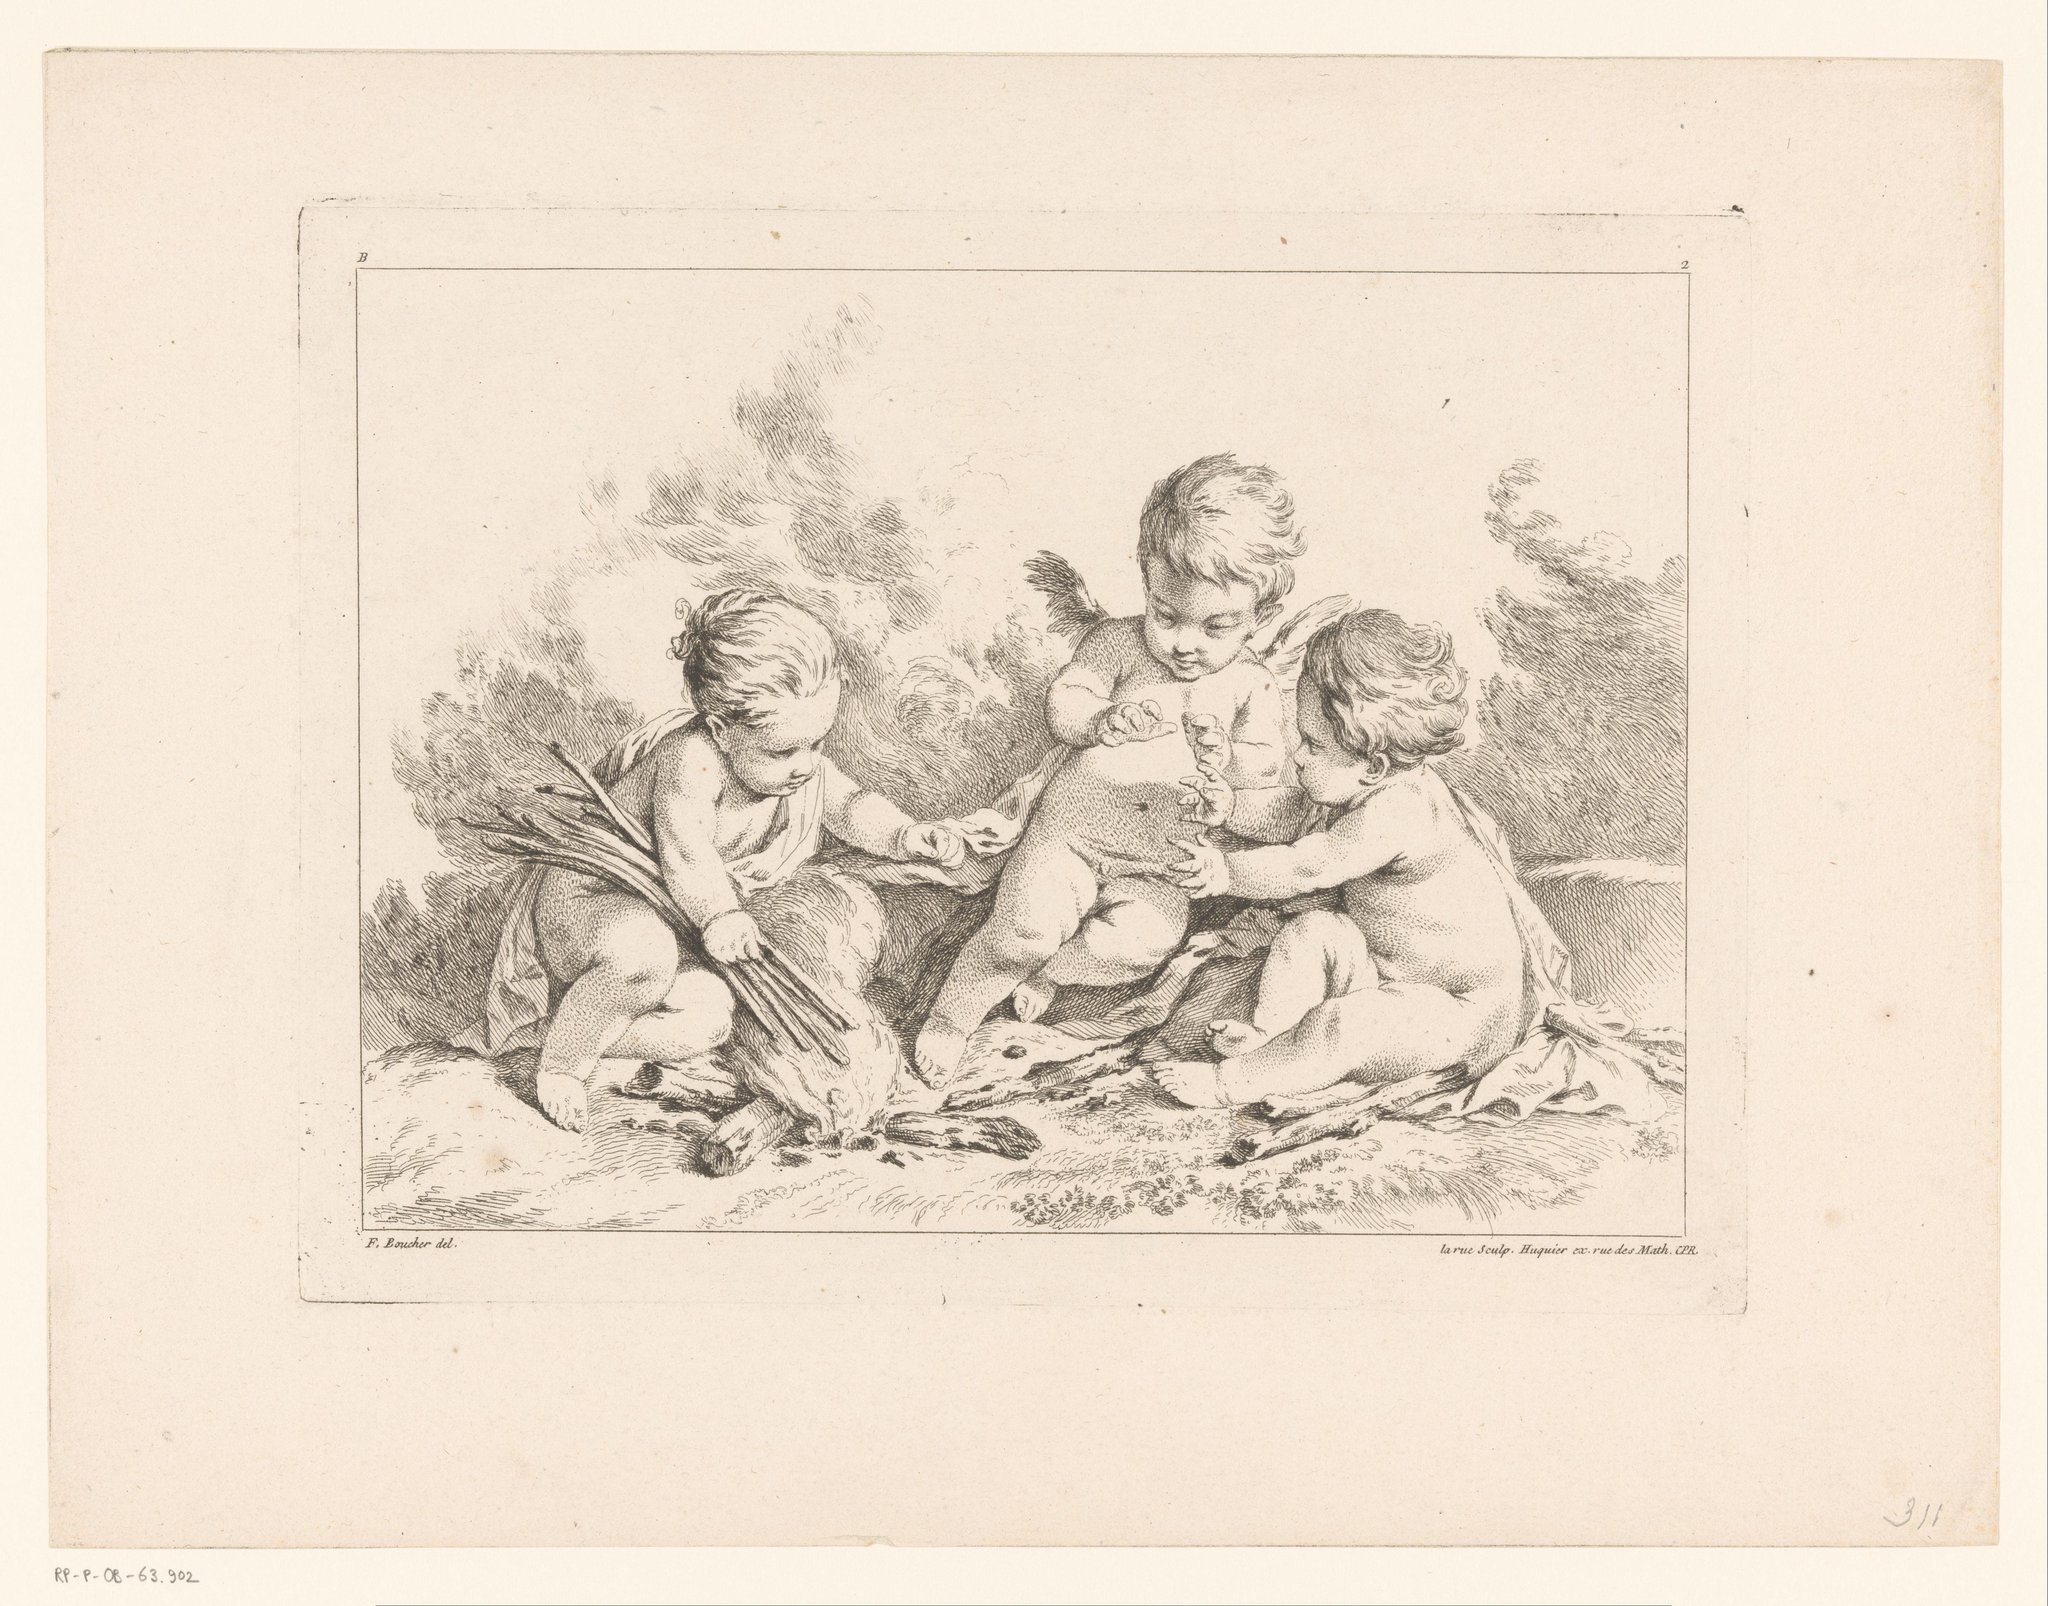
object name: print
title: Drie amors zich warmend bij vuur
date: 1741-1765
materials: paper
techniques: etching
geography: france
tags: cupids: 'amores', 'amoretti', 'putti'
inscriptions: collector's mark: Lugt 240